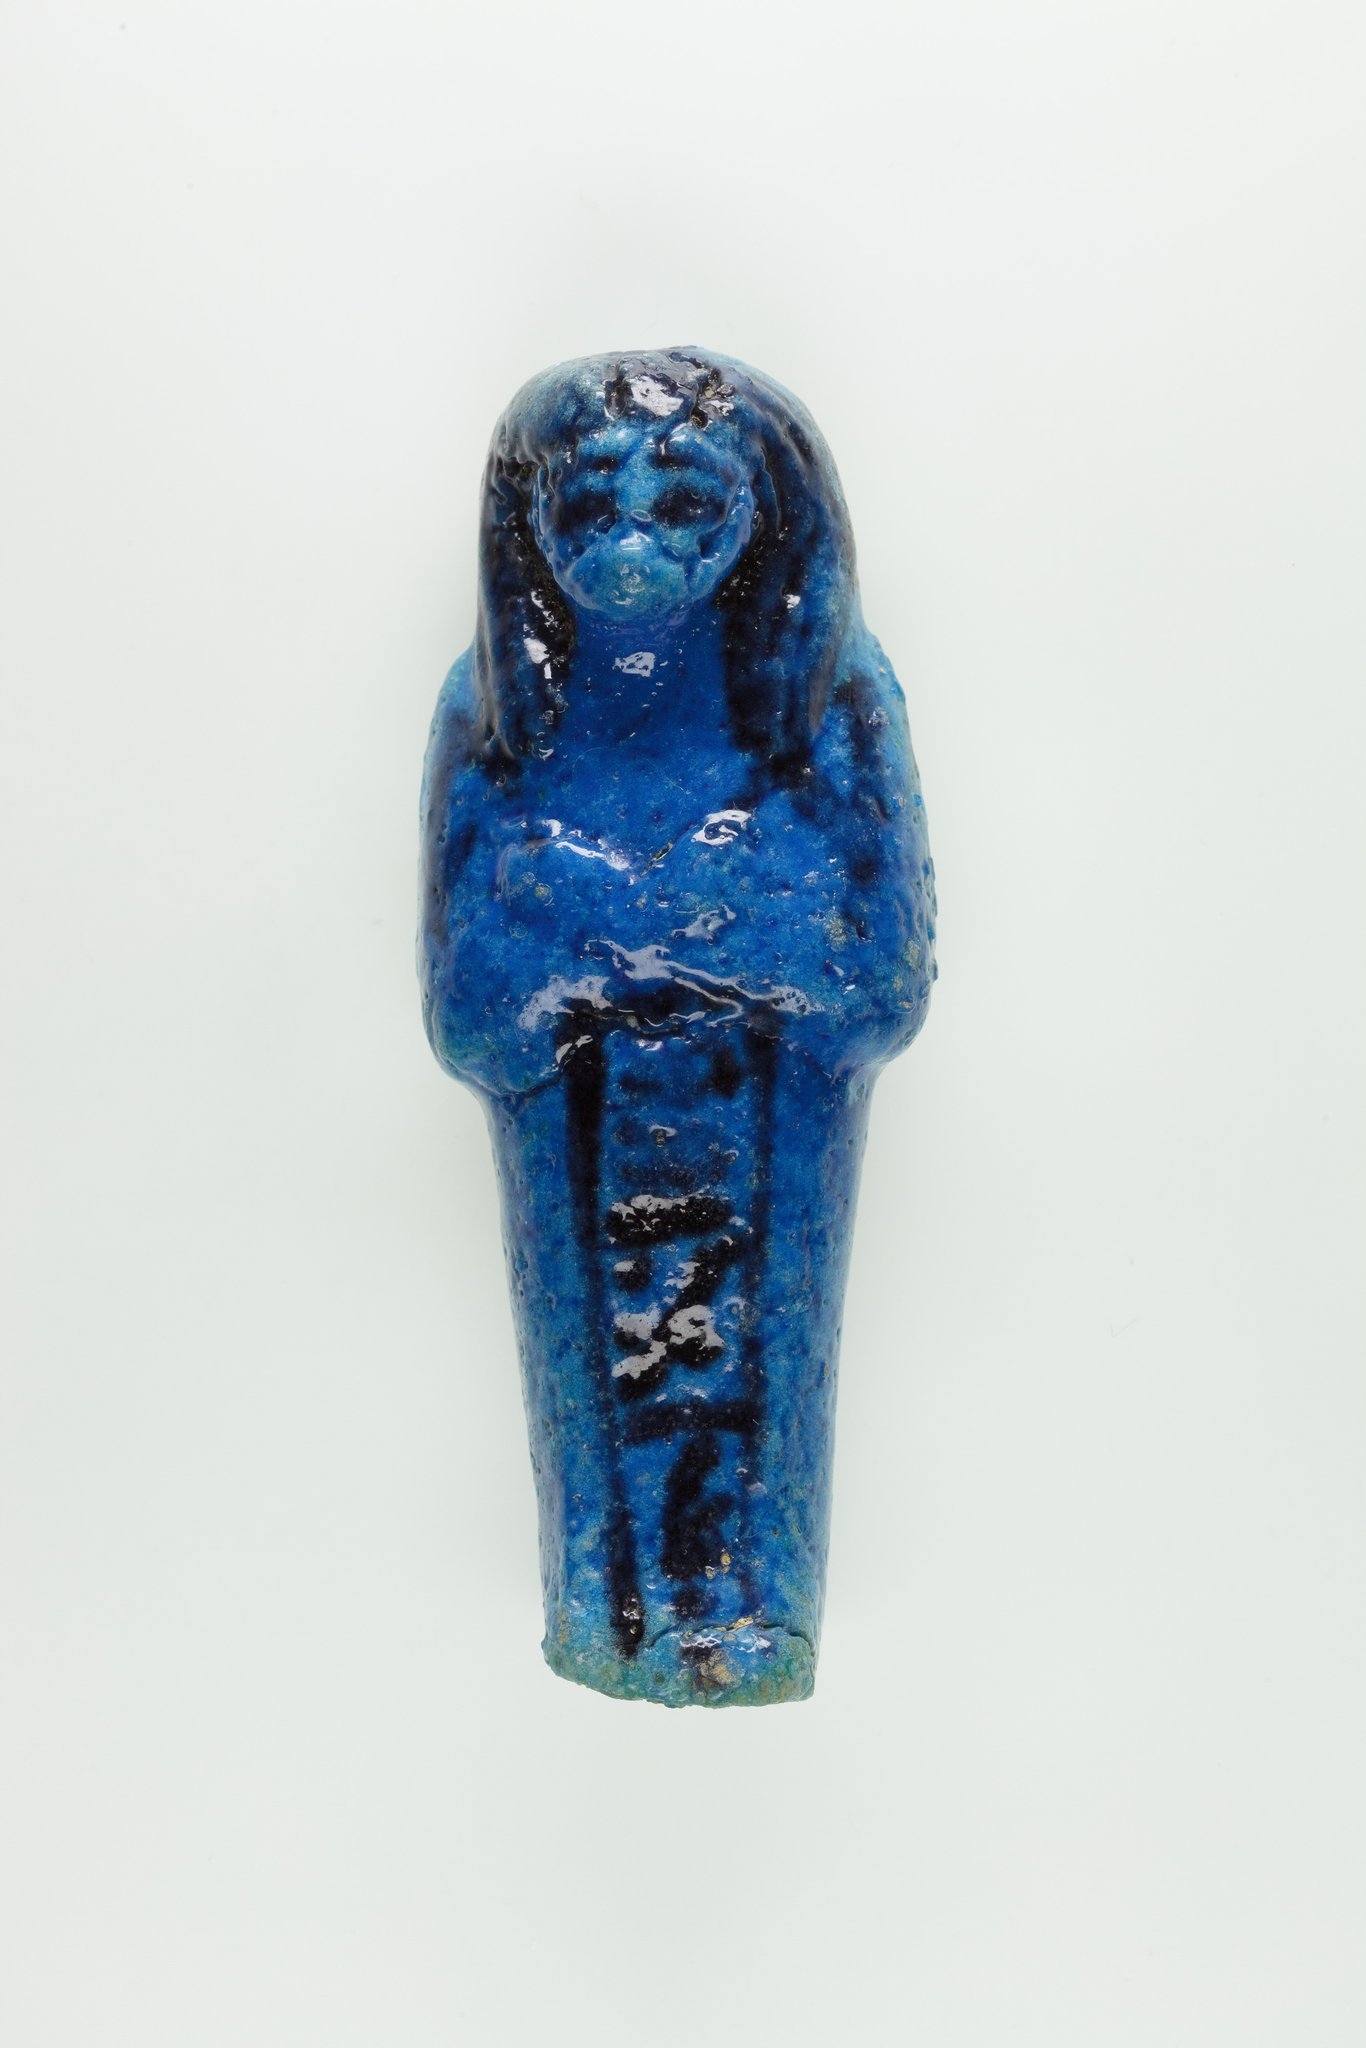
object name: shabti, worker, nauny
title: Worker Shabti of Nauny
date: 1050 BCE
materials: faience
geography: egypt